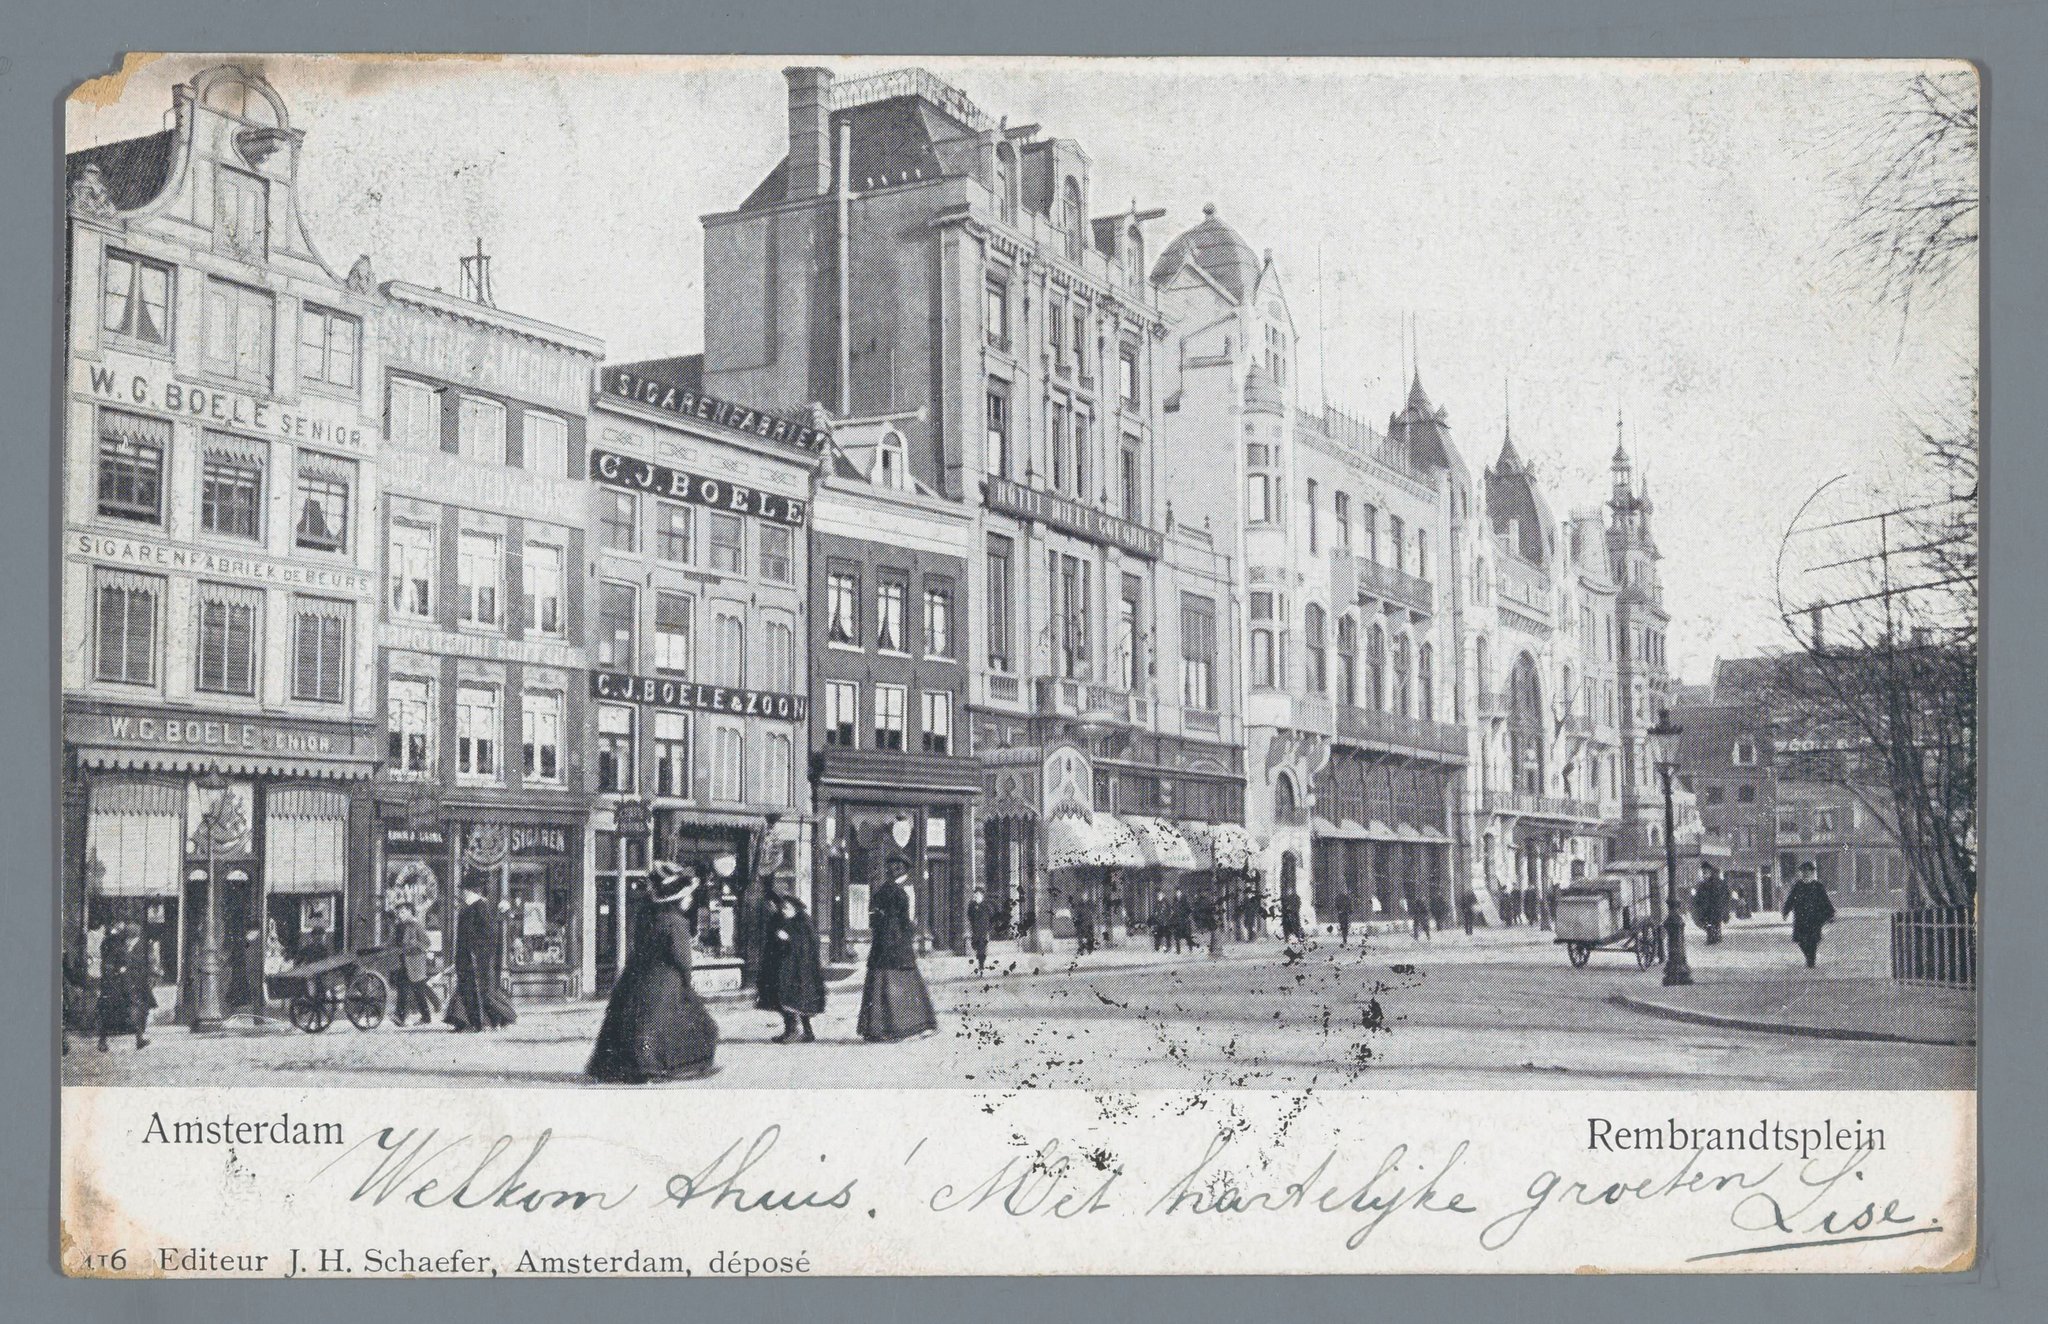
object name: photomechanical print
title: Amsterdam, Rembrandtsplein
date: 1904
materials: cardboard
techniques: writing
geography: amsterdam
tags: square, place, circus, etc.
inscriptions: number: ‘416’